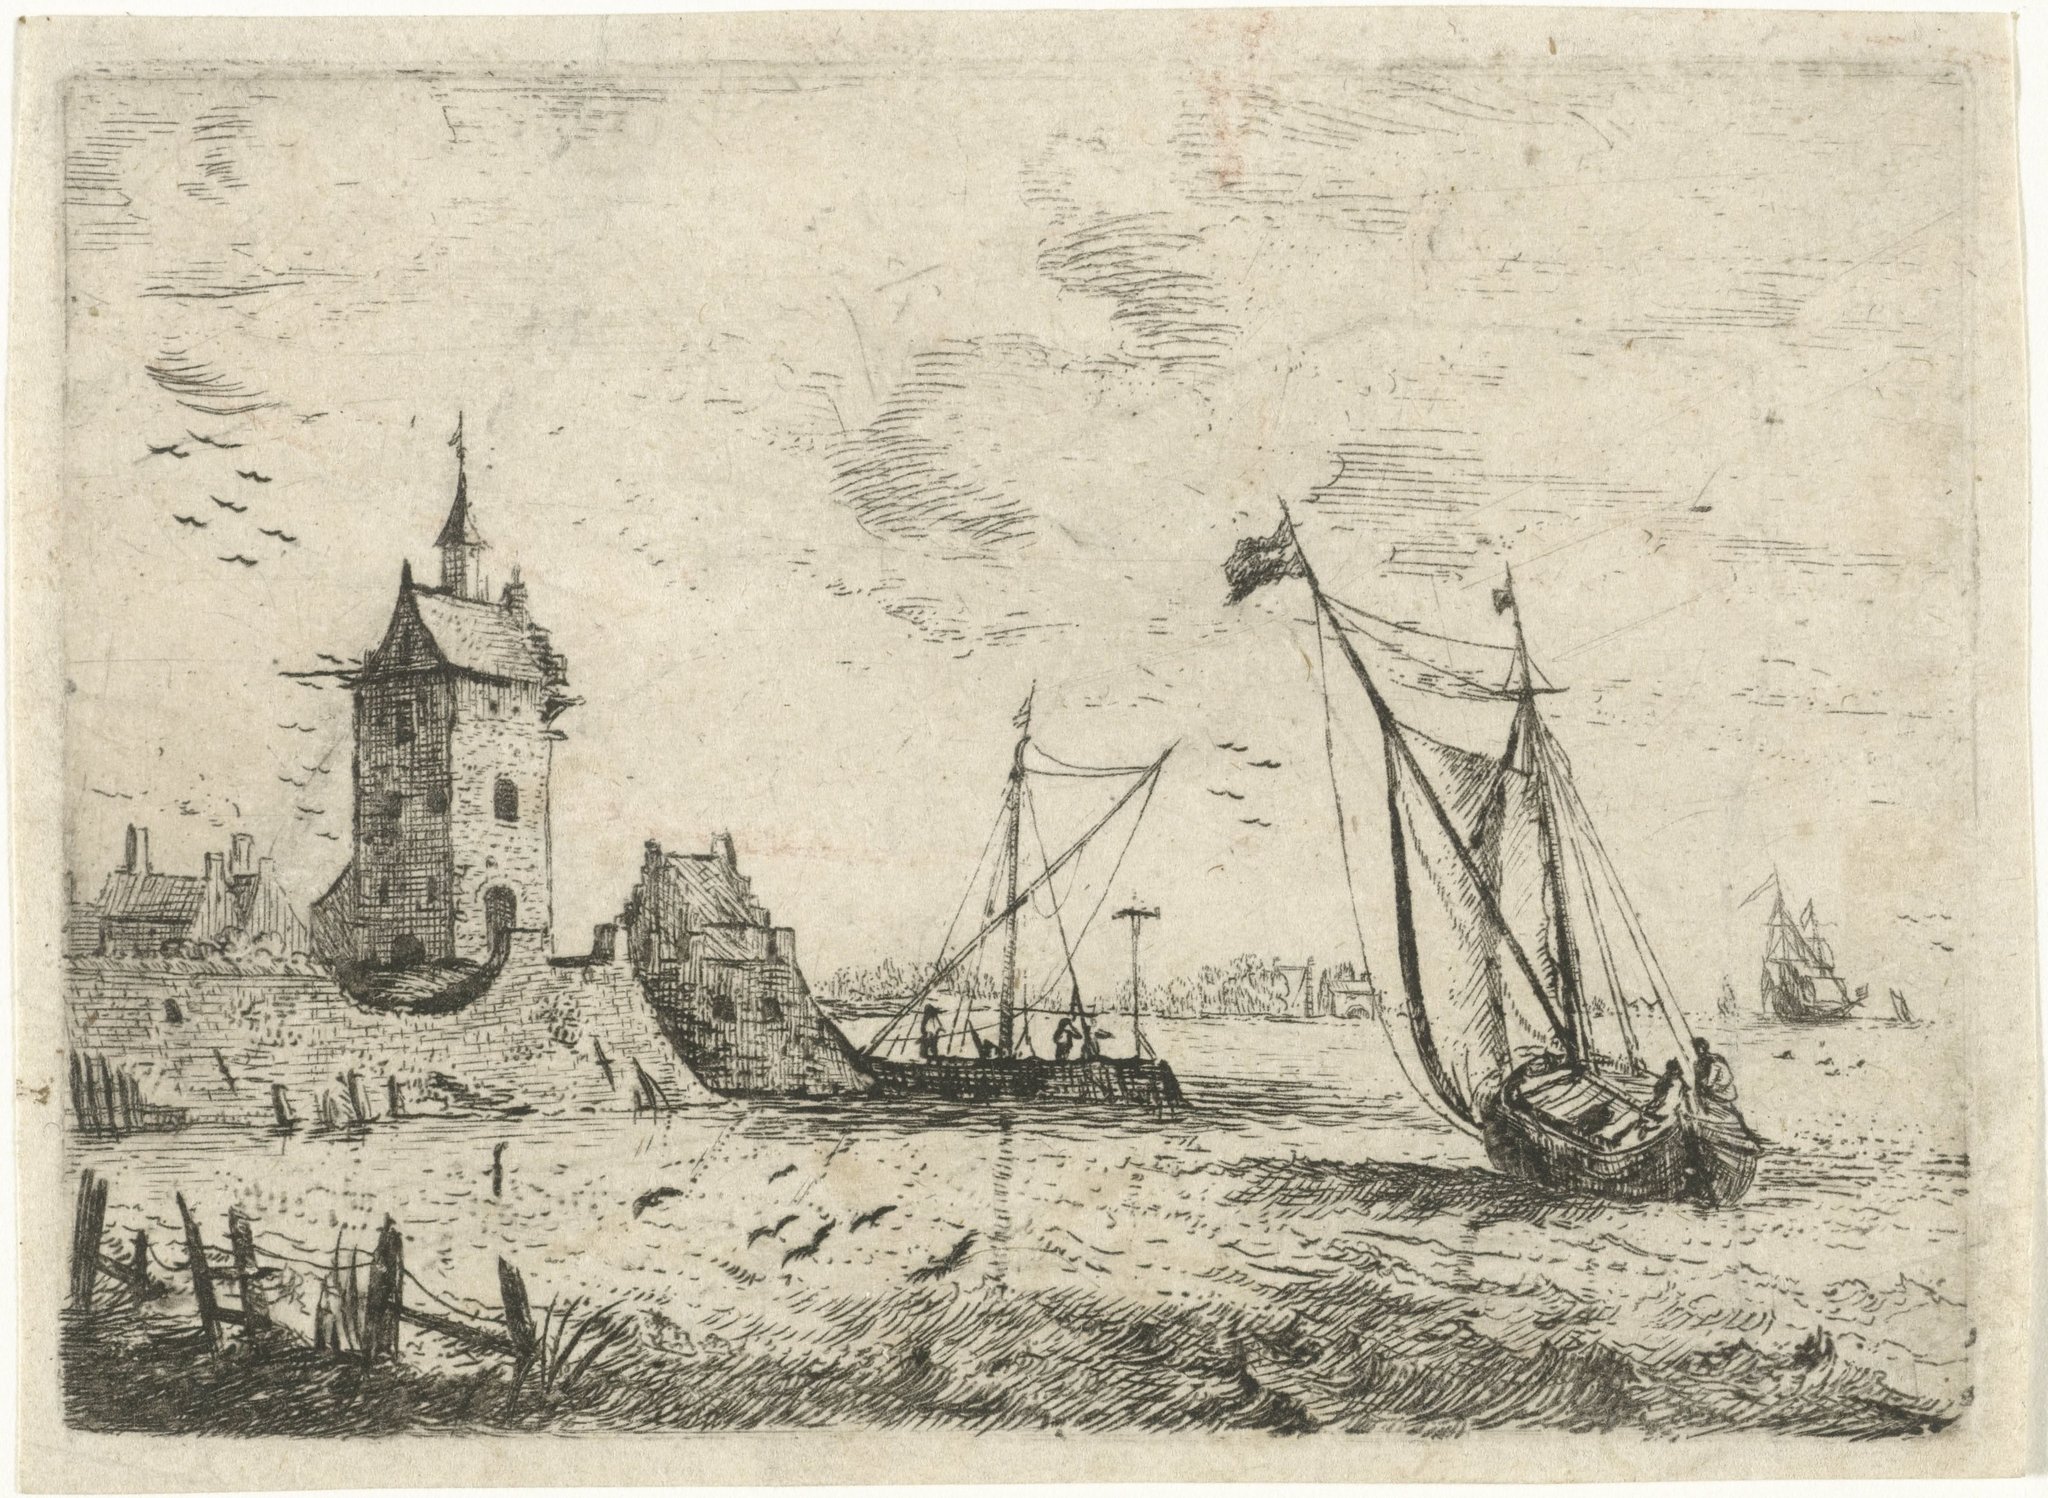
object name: print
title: Havengezicht met een uitkijktoren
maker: bonaventura peeters (i)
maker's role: draughtsman, painter, print maker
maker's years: 1614-1652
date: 1624-1652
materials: paper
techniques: engraving, etching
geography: antwerp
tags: pier, quay, wharf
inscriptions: collector's mark: Lugt 2228